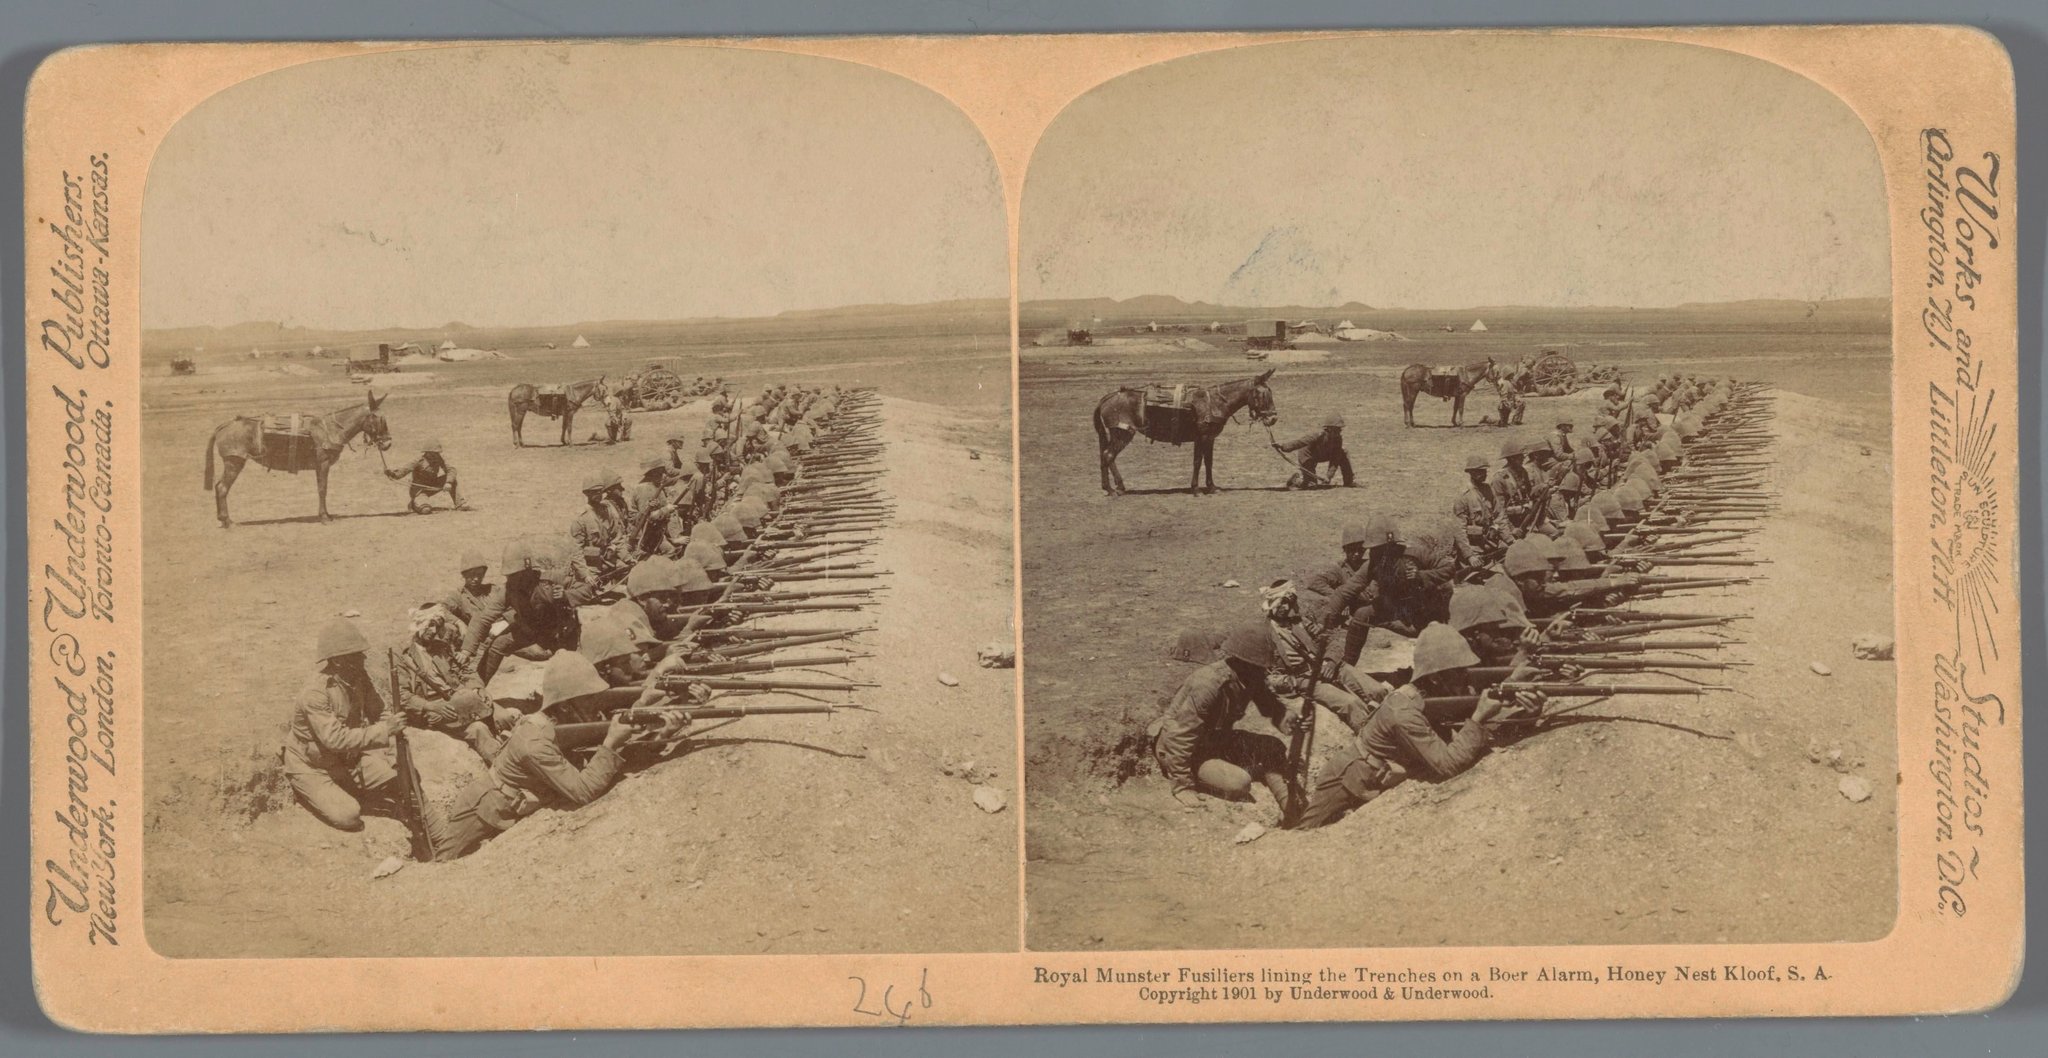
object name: stereograph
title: Geënsceneerde voorstelling van de Royal Munster Fusiliers in een loopgraaf in Zuid-Afrika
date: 1901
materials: cardboard, photographic support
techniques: albumen print, photography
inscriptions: name: ‘Works and Studios Sun Sculpture trade mark Arlington N.J. Littleton N.H. Washington D.C.’, number: ‘220’